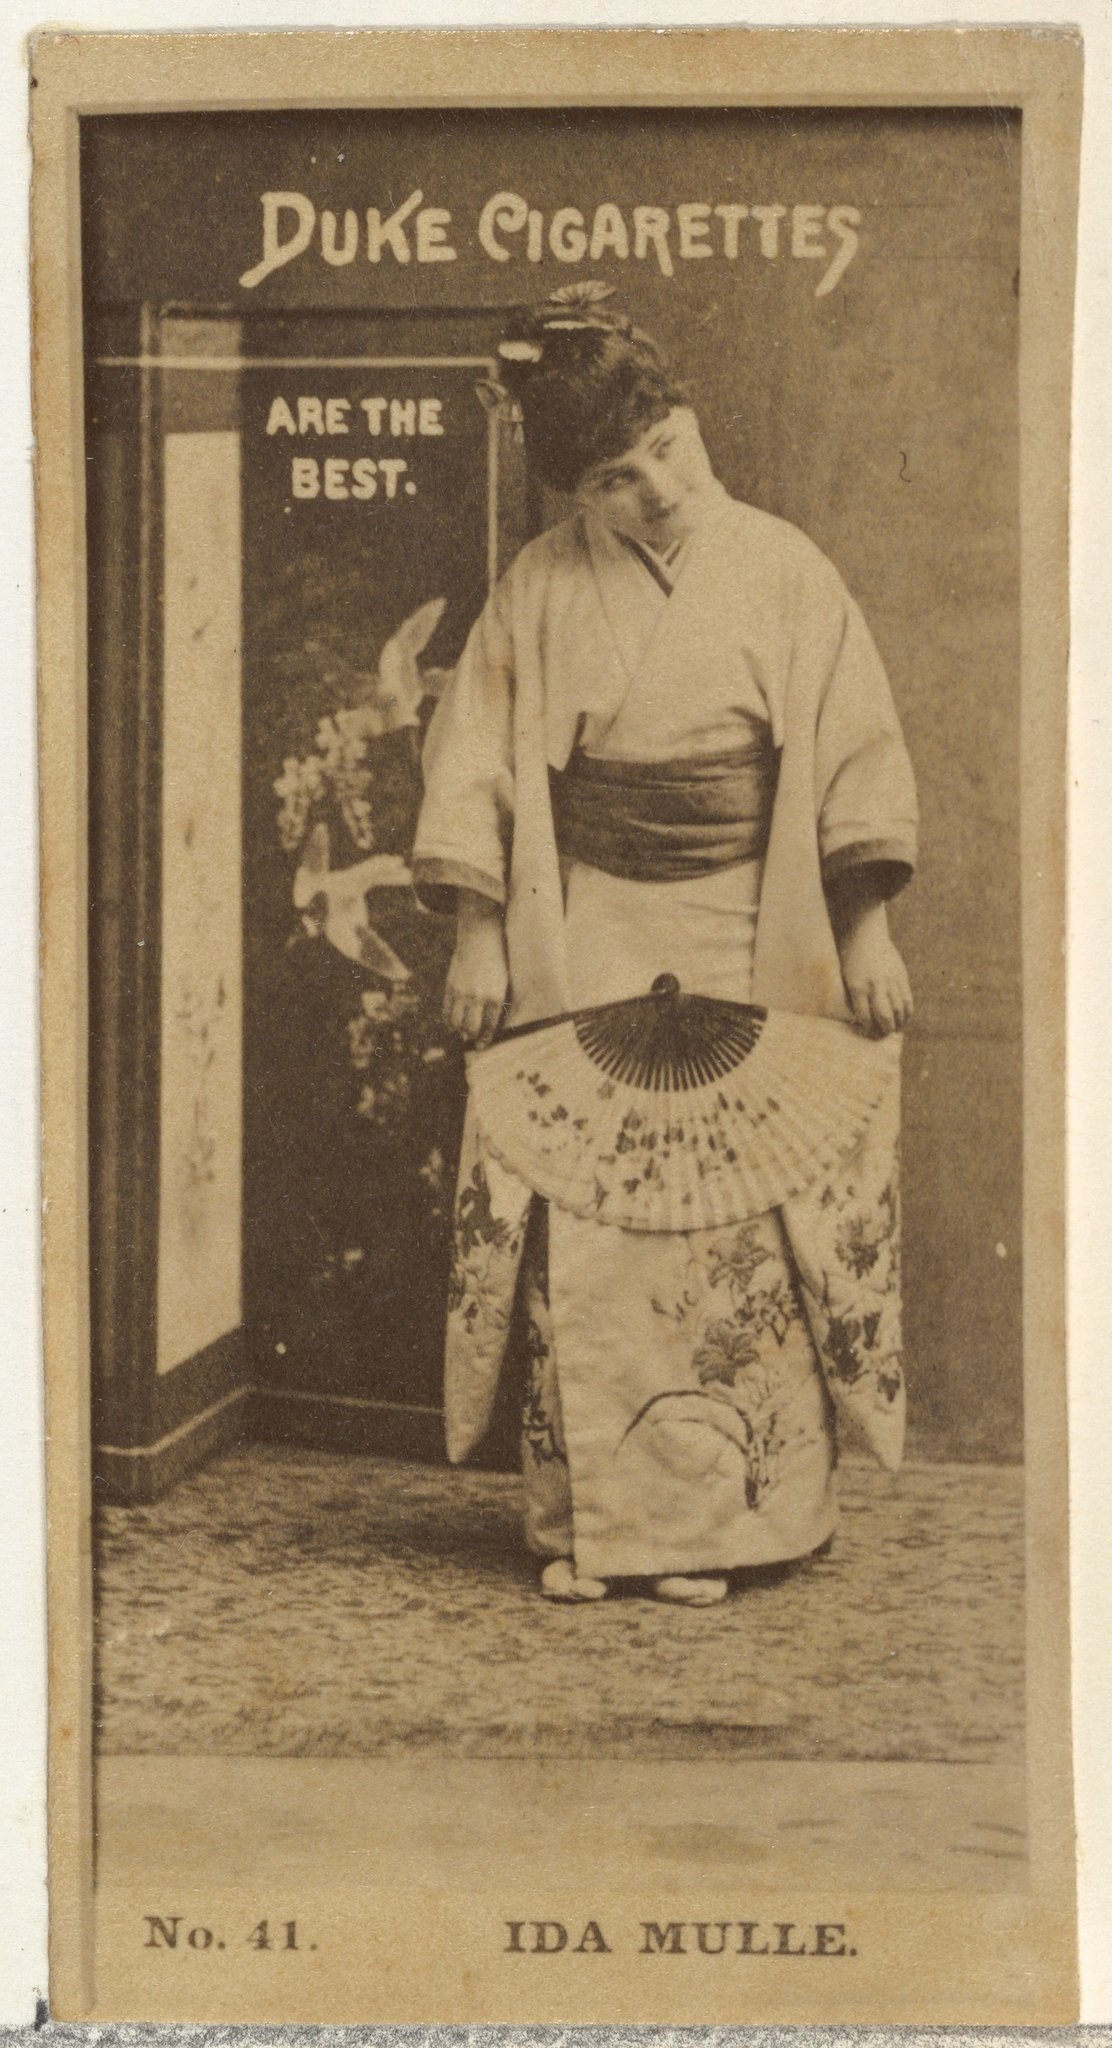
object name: photograph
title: Card Number 41, Ida Mulle, from the Actors and Actresses series (N145-6) issued by Duke Sons & Co. to promote Duke Cigarettes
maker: w. duke, sons & co.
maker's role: publisher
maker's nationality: american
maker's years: 1870-1920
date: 1880-1889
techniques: albumen silver print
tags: portraits,women,actresses